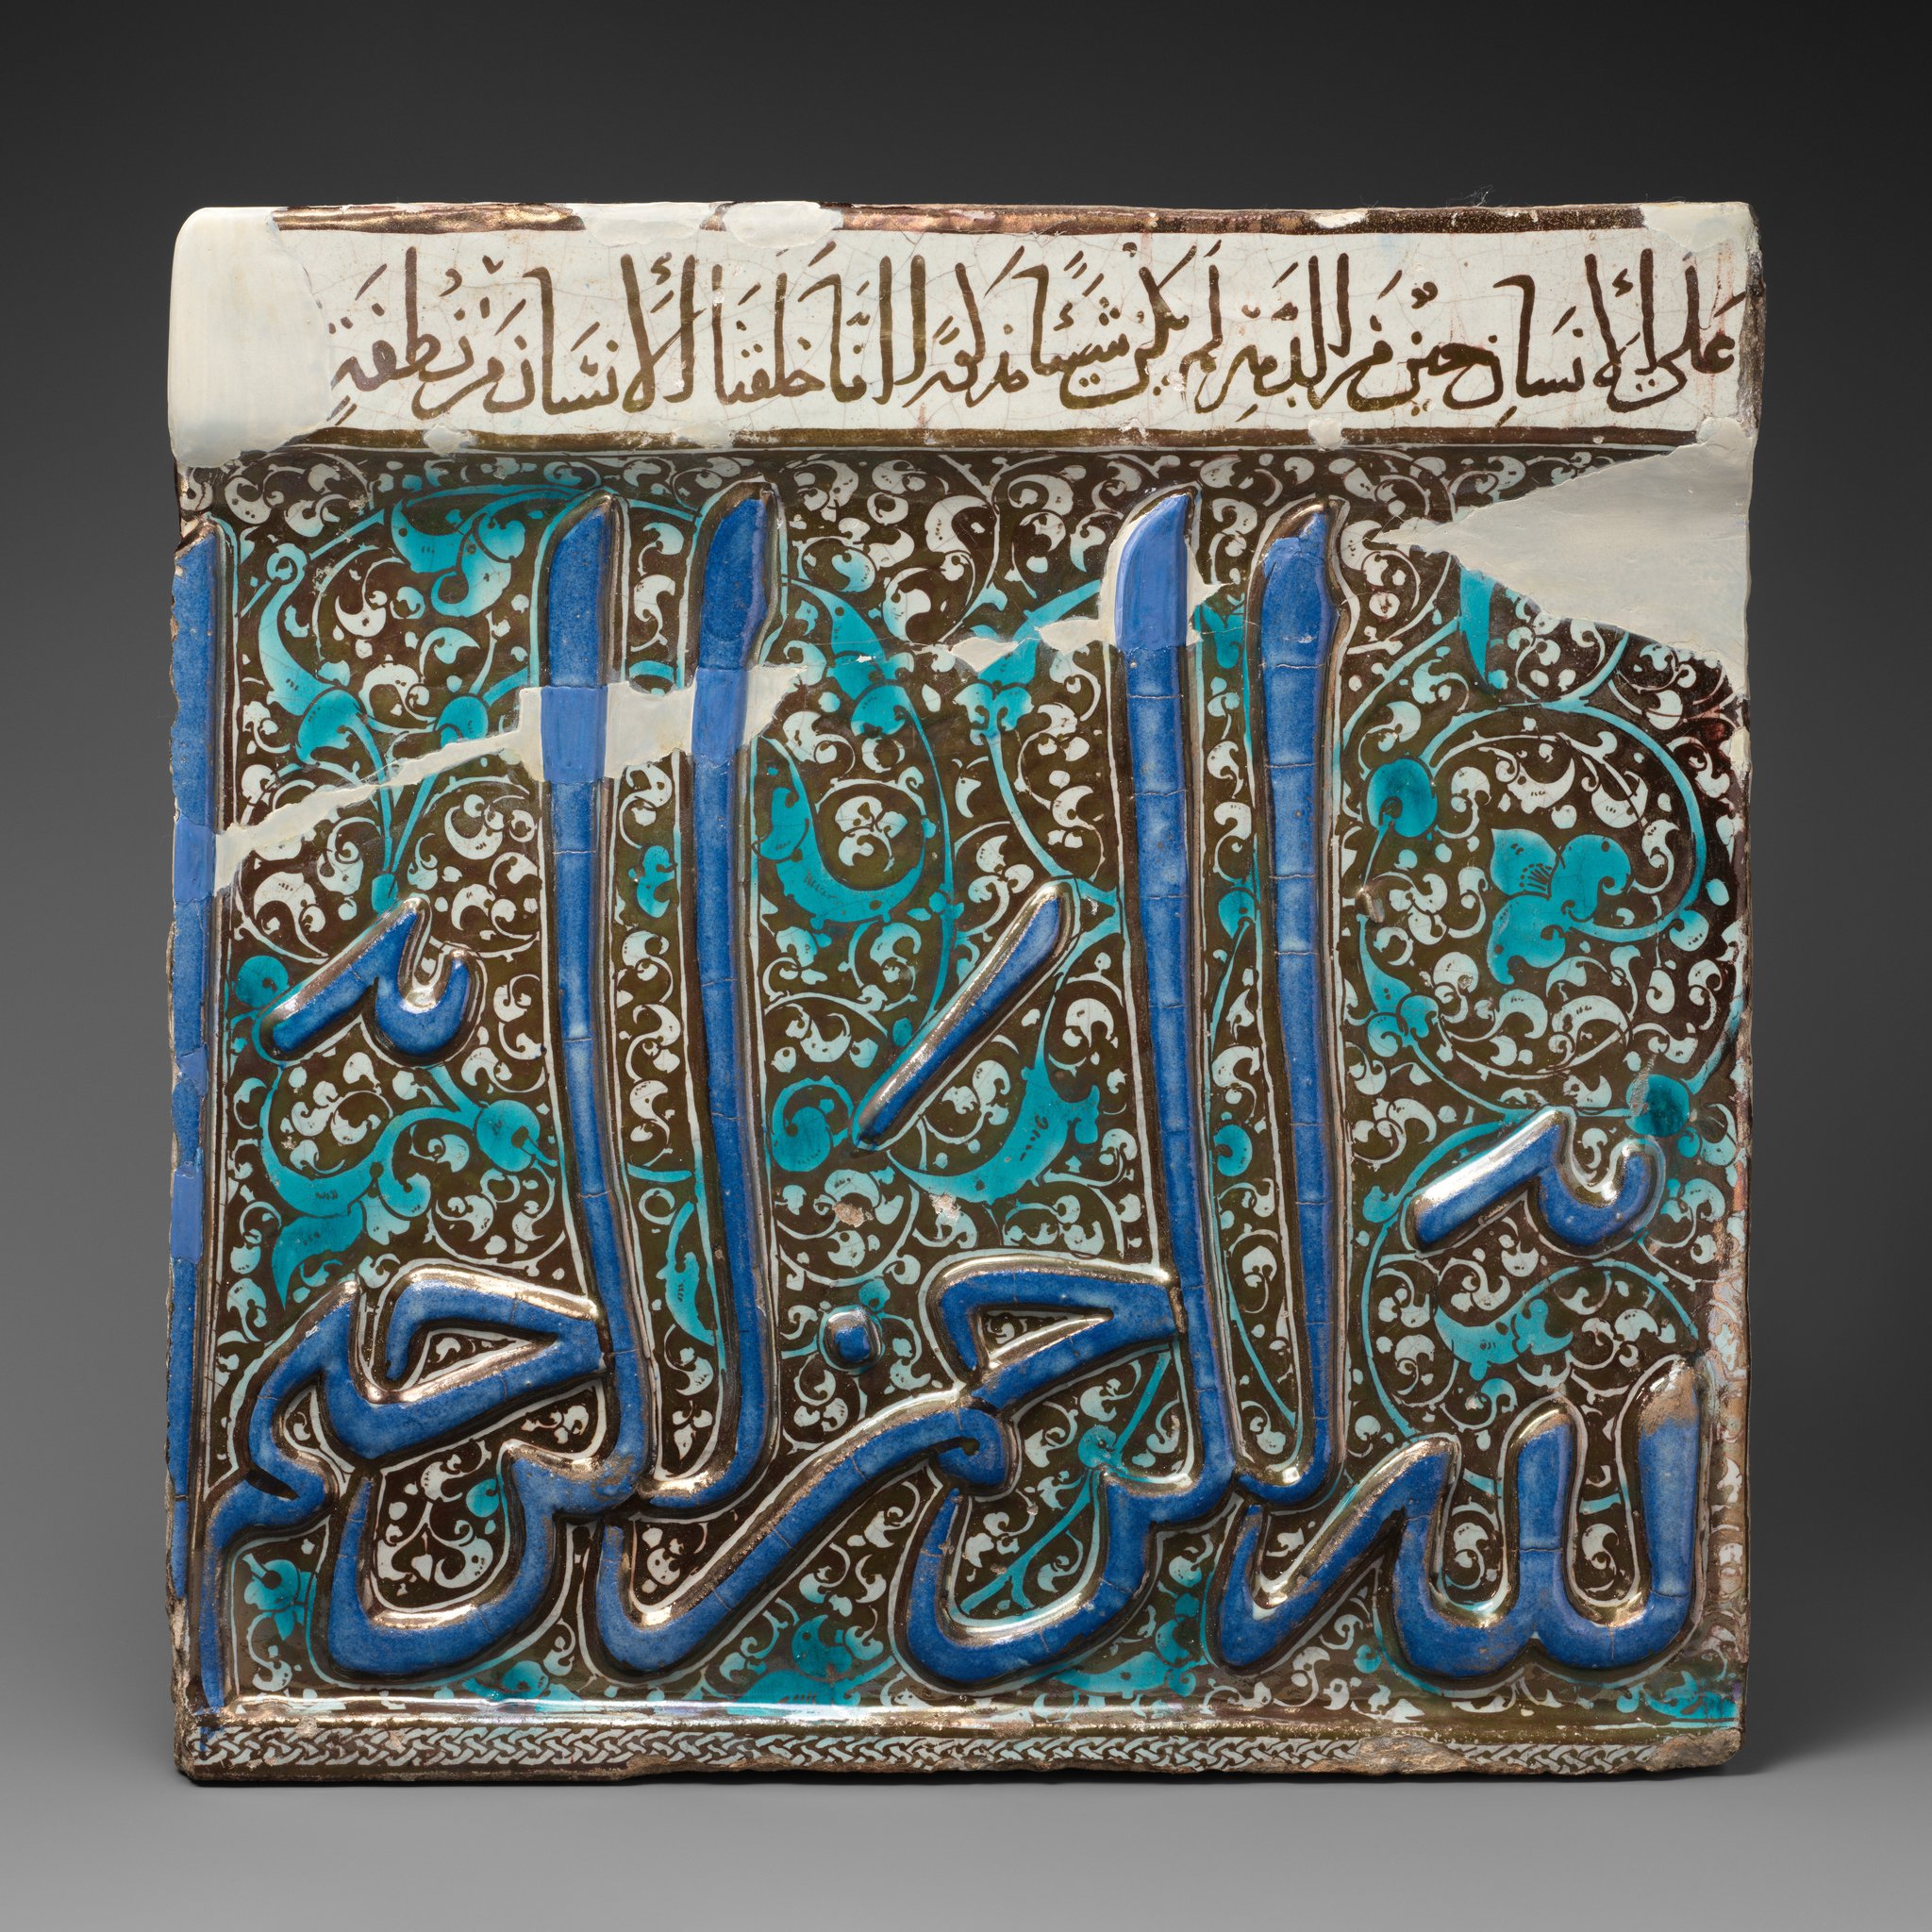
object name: tile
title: Tile from a Frieze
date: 1251-1300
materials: stonepaste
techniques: luster painting, molding, overglaze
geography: iran